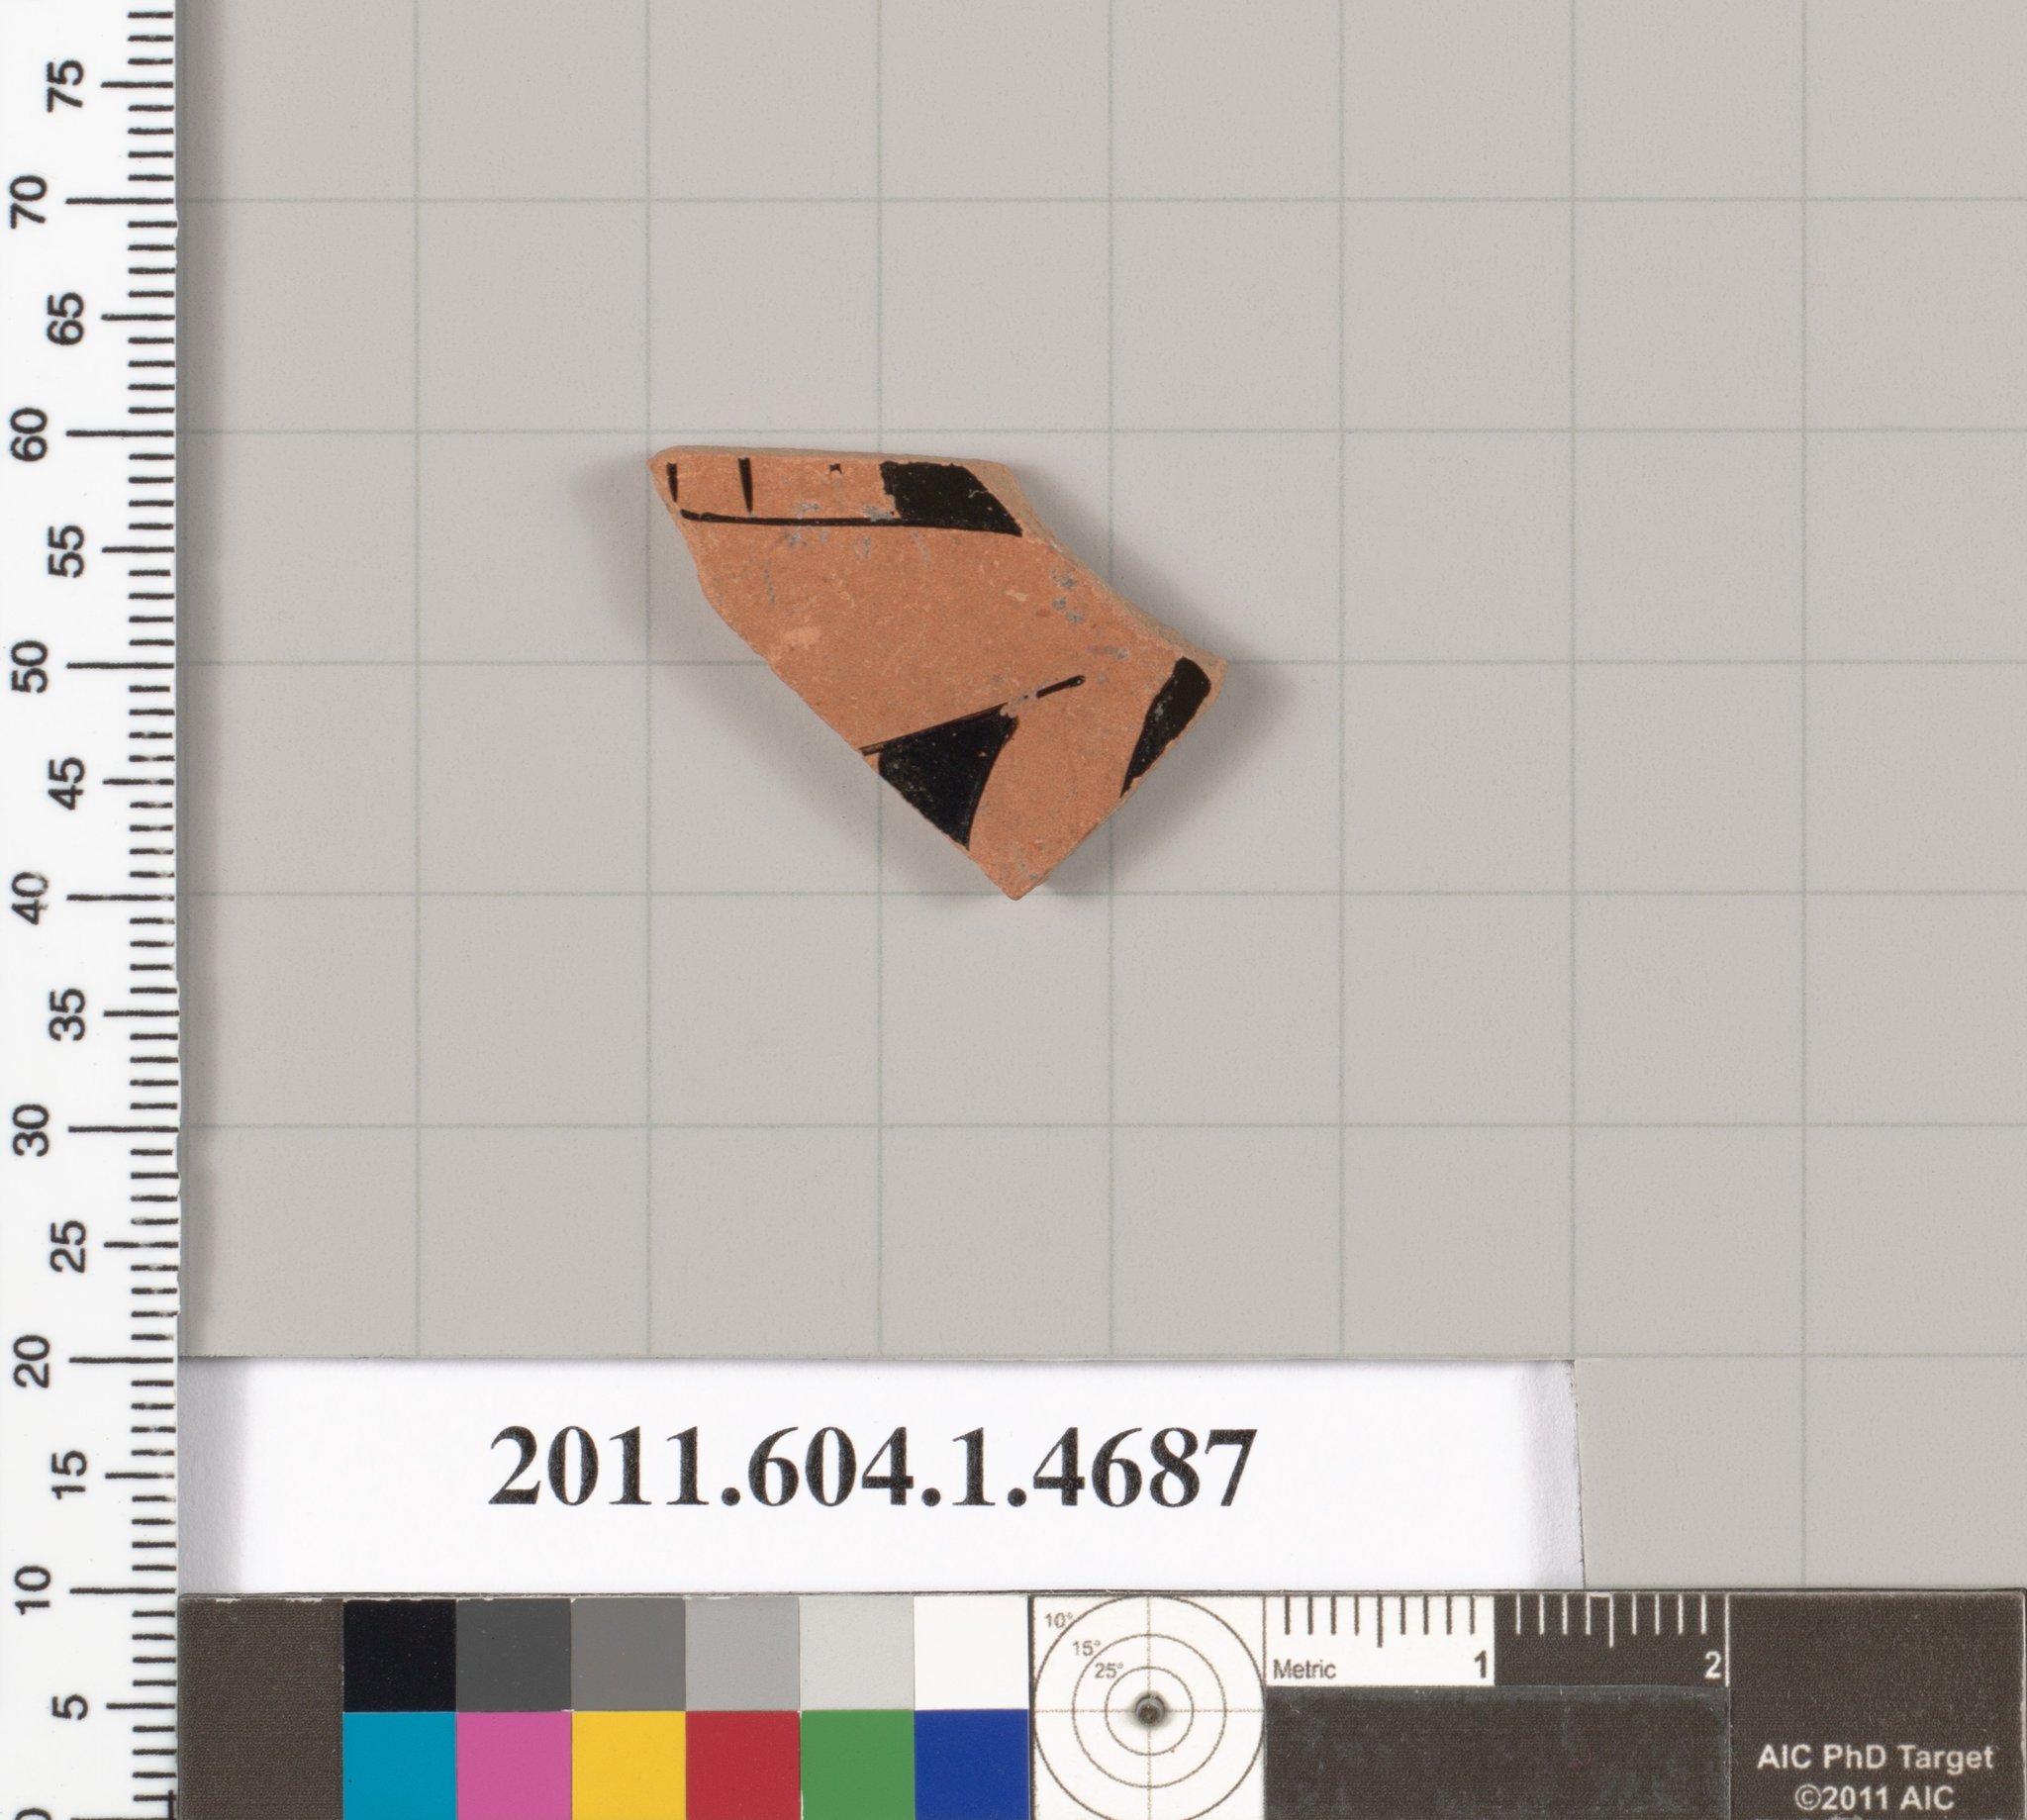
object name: kylix fragment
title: Terracotta fragment of a kylix (drinking cup)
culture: greek, attic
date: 500-480 BCE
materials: terracotta